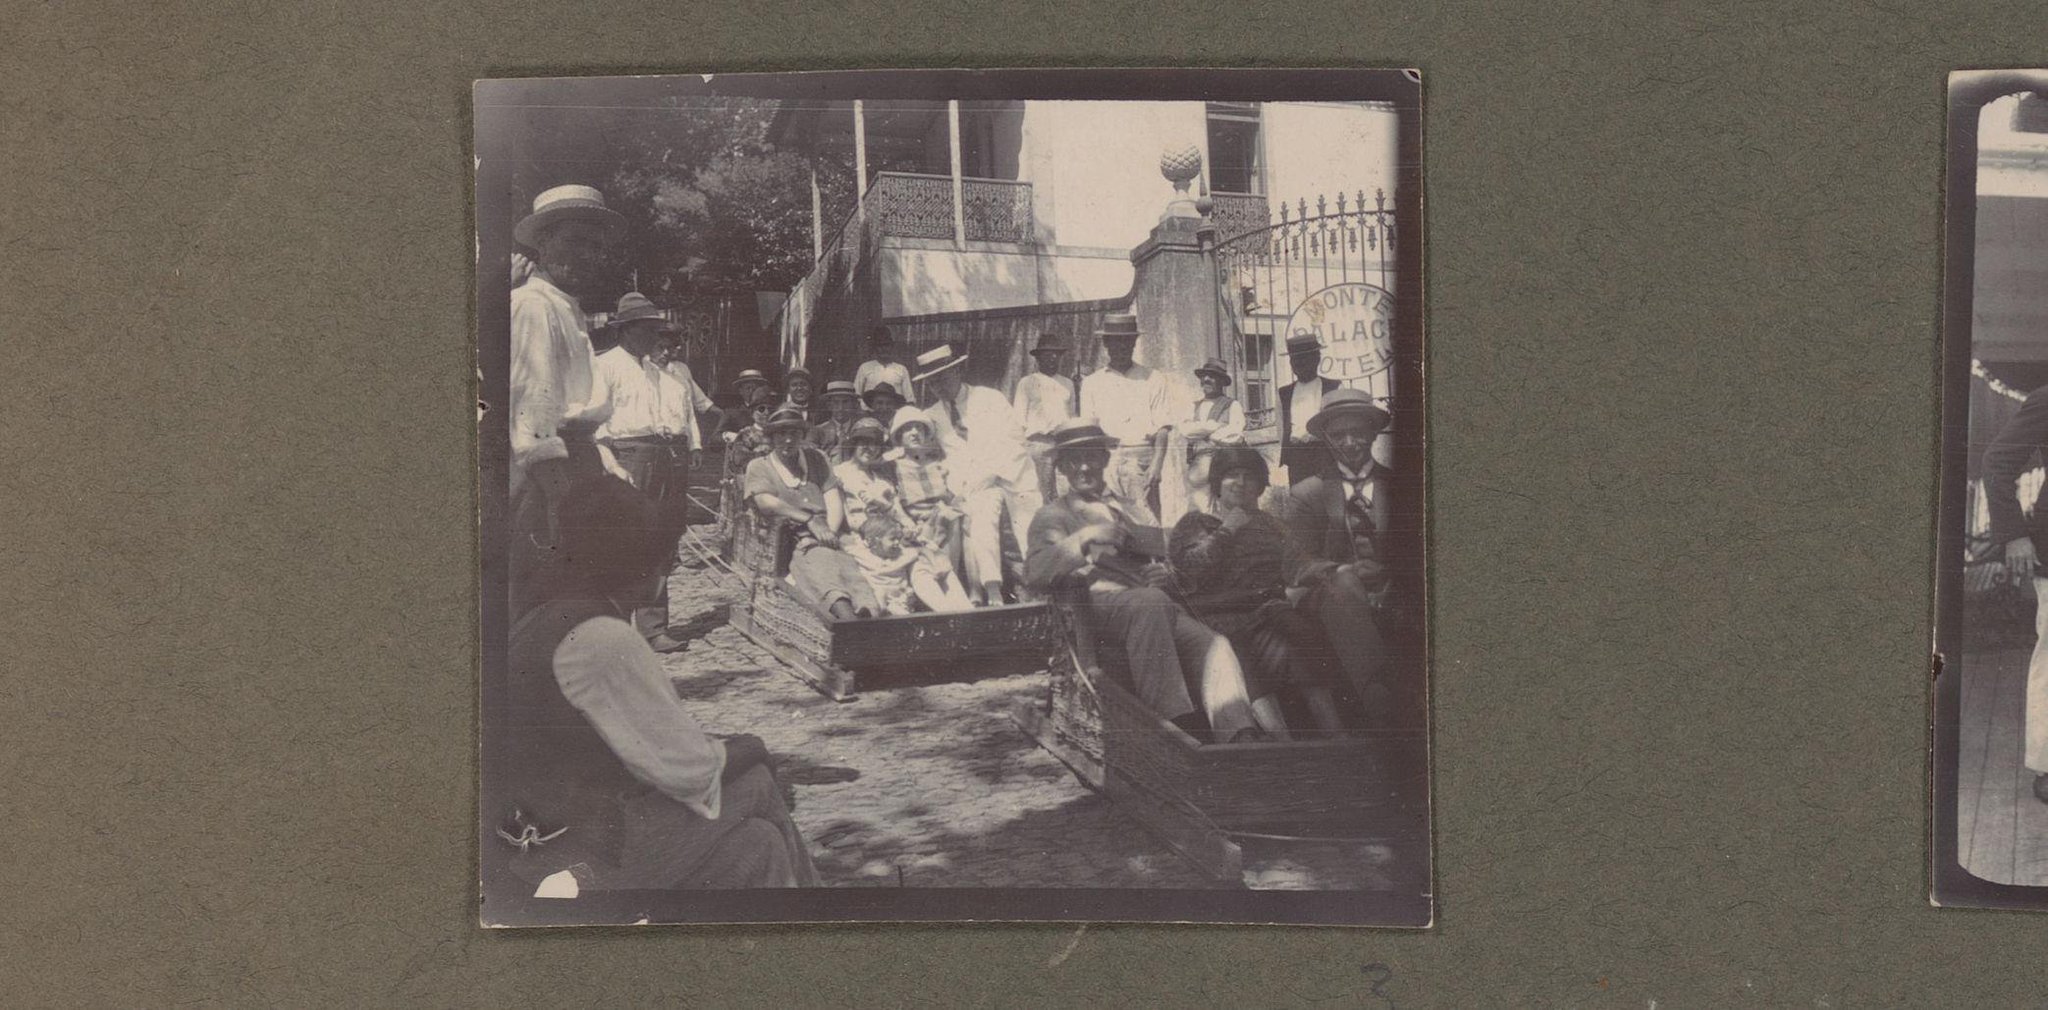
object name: photograph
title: Straatgezicht te Madeira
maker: Anonymous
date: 1925-1927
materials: photographic support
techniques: photography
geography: suriname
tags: jetten, familie, moengo, madeira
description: Straatgezicht tijdens bezoek aan Madeira. Foto op een bladzijde van een los albumblad. Onderdeel van het ensemble met foto's van de familie van ingenieur Jetten in de mijnbouwstad Moengo in Suriname.